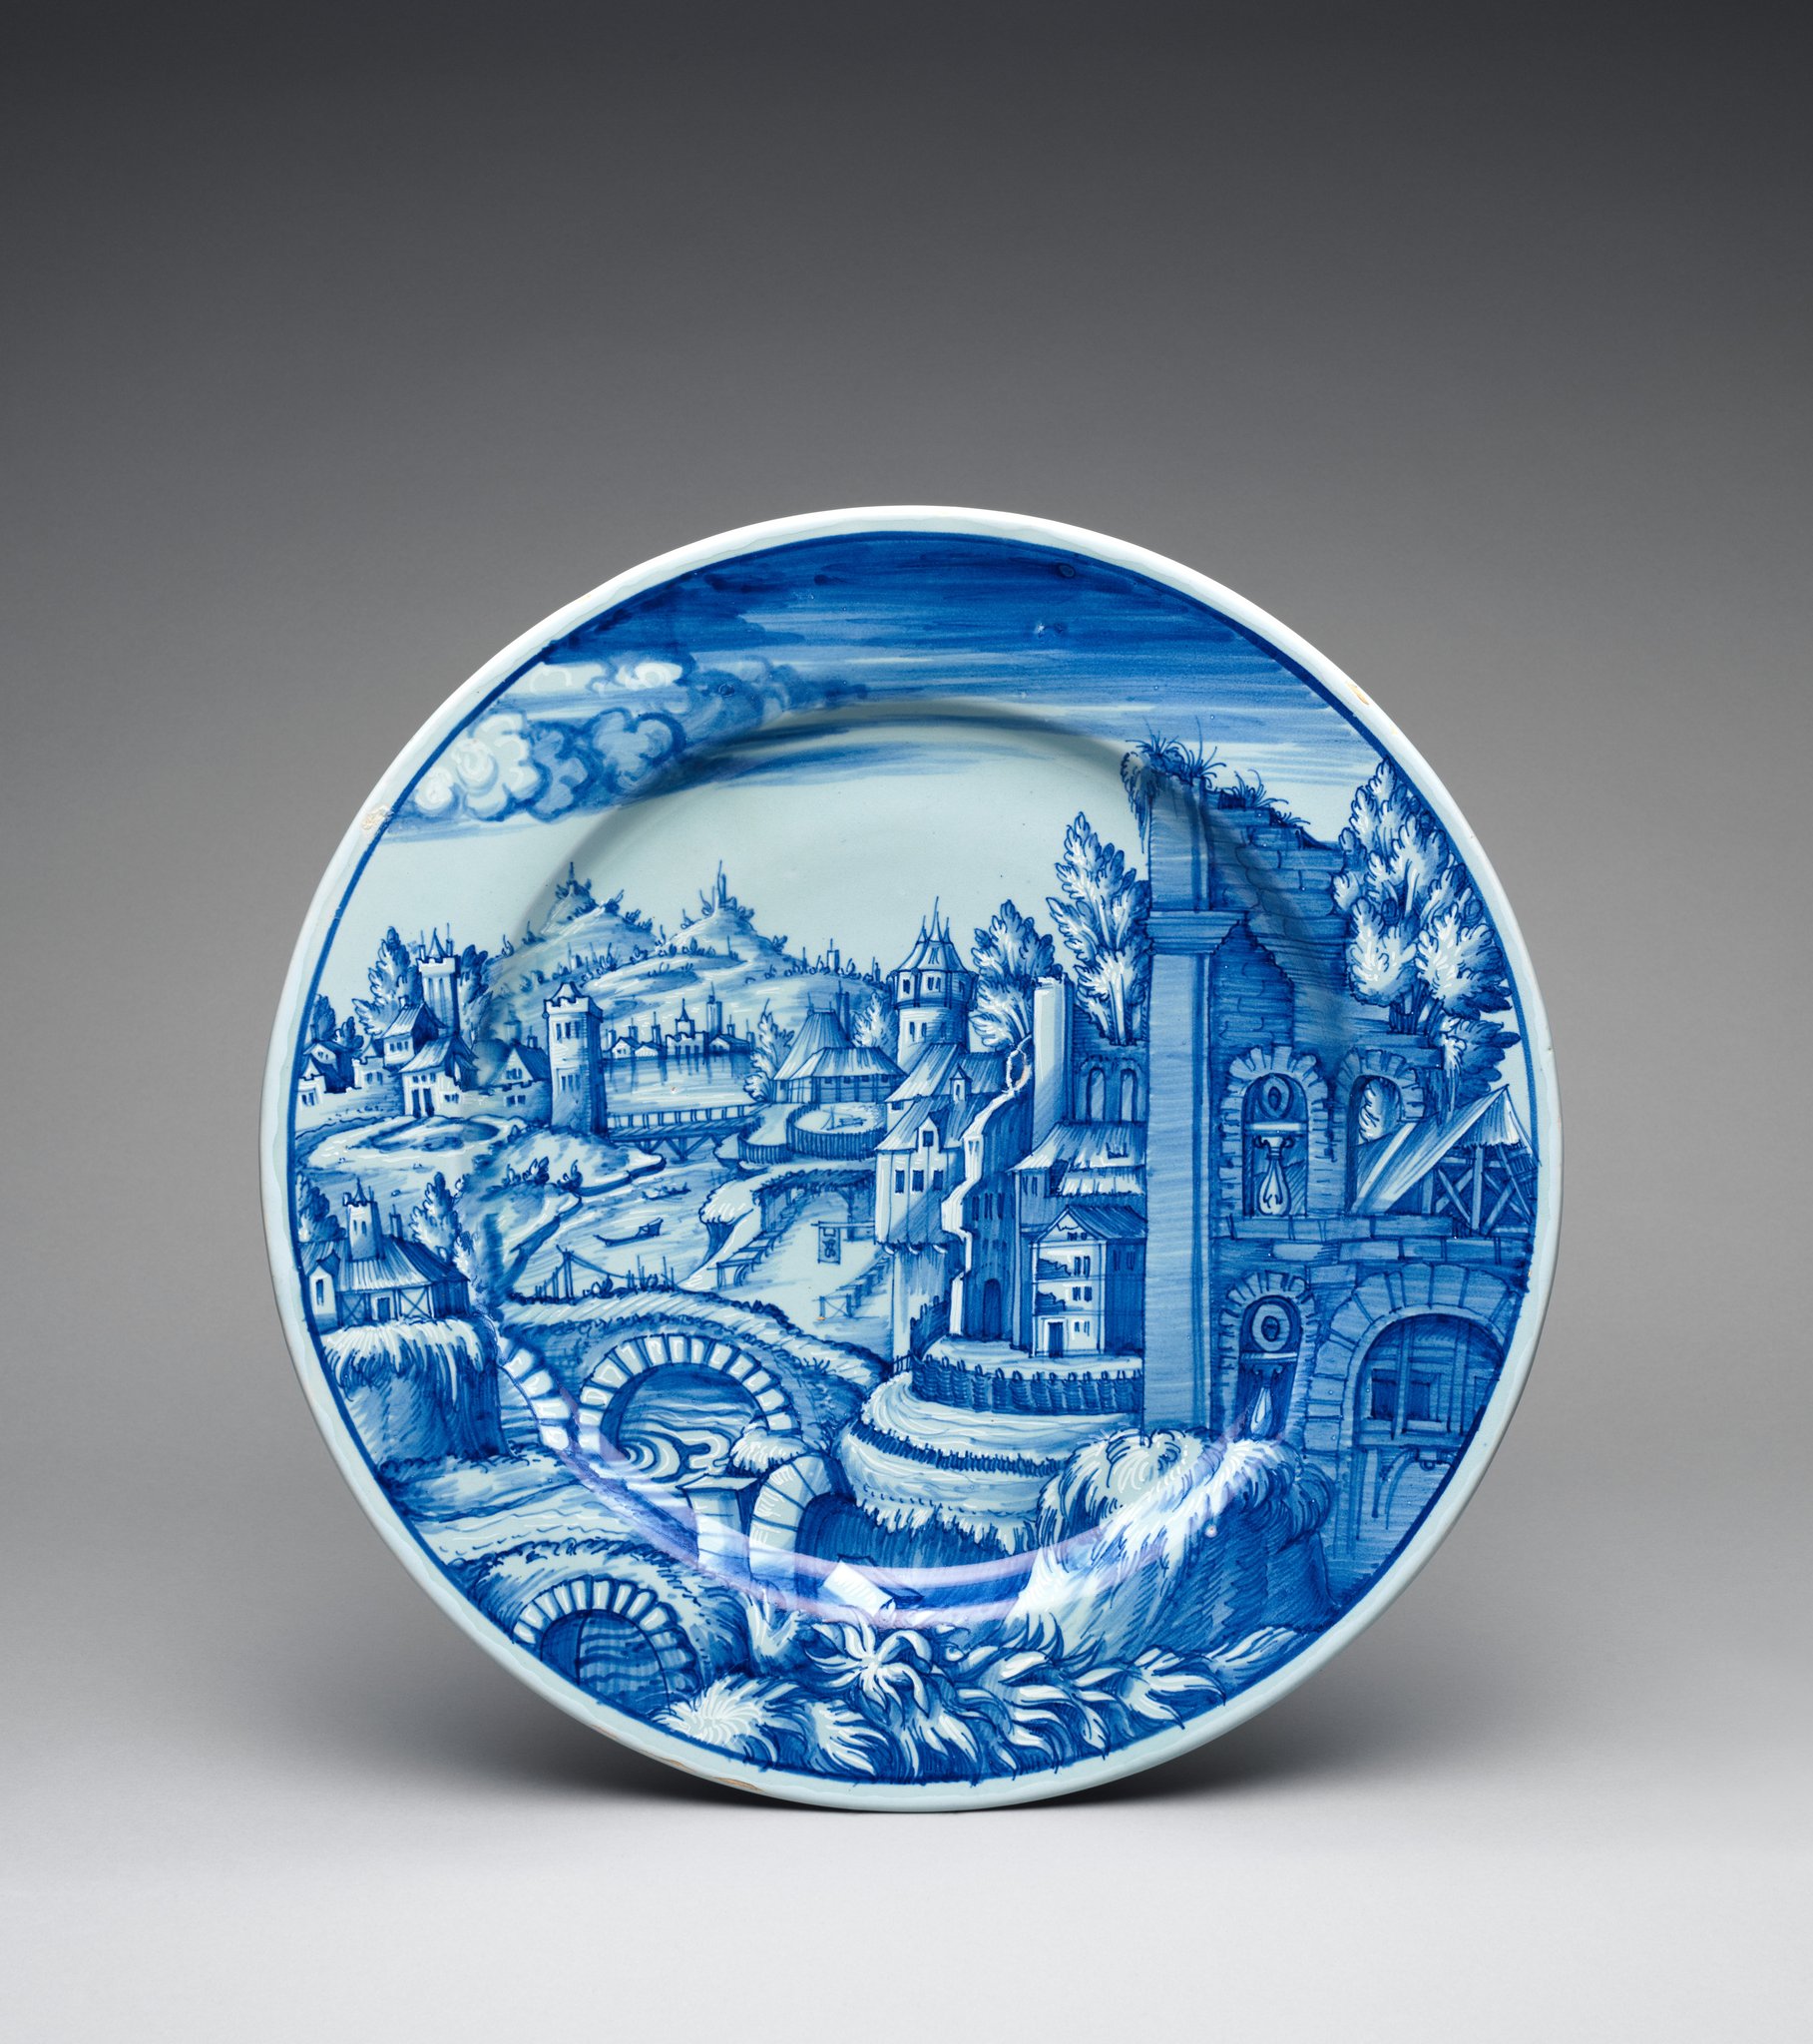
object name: charger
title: Dish with a Landscape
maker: jacopo da pesaro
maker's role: maker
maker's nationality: italian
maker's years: 1507-1555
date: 1545-1550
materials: earthenware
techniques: highlighting, painting, glazing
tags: buildings,landscapes